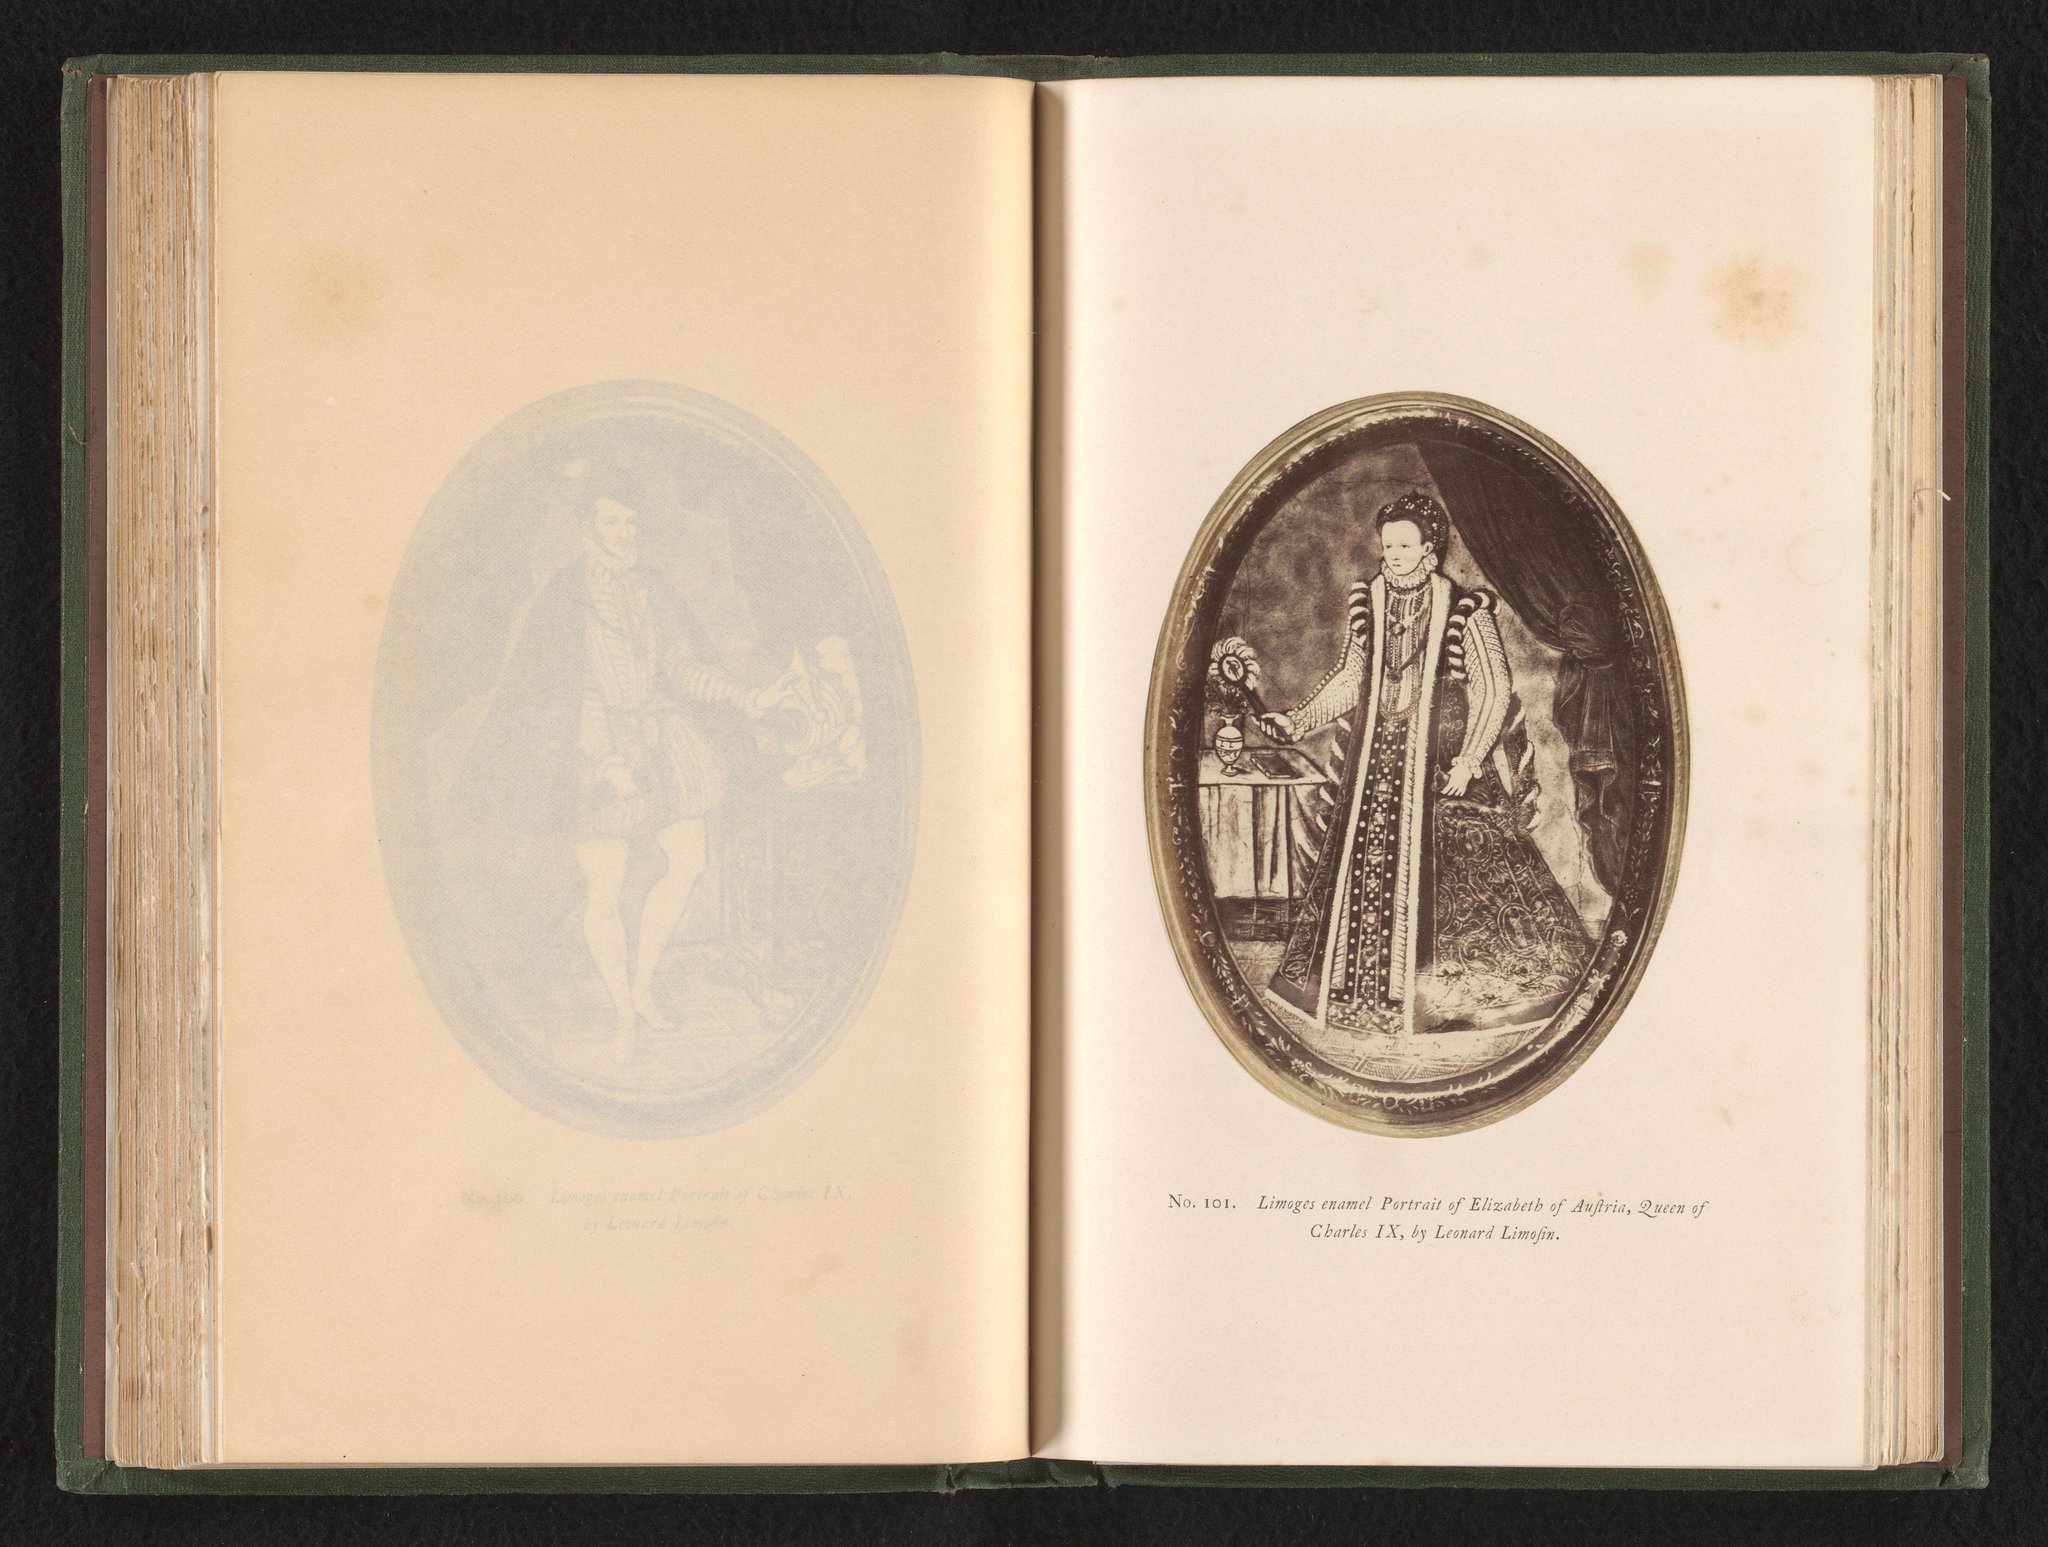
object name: page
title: Fotoreproductie van een geëmailleerd portret van Elisabeth van Oostenrijk door Léonard Limosin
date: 1851-1861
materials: paper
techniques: albumen print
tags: vienna, historical persons - bb - woman, enamelling ~ applied arts, queen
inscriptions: number: ‘No. 101.’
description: Foto op derde ongenummerde pagina na pagina 58.